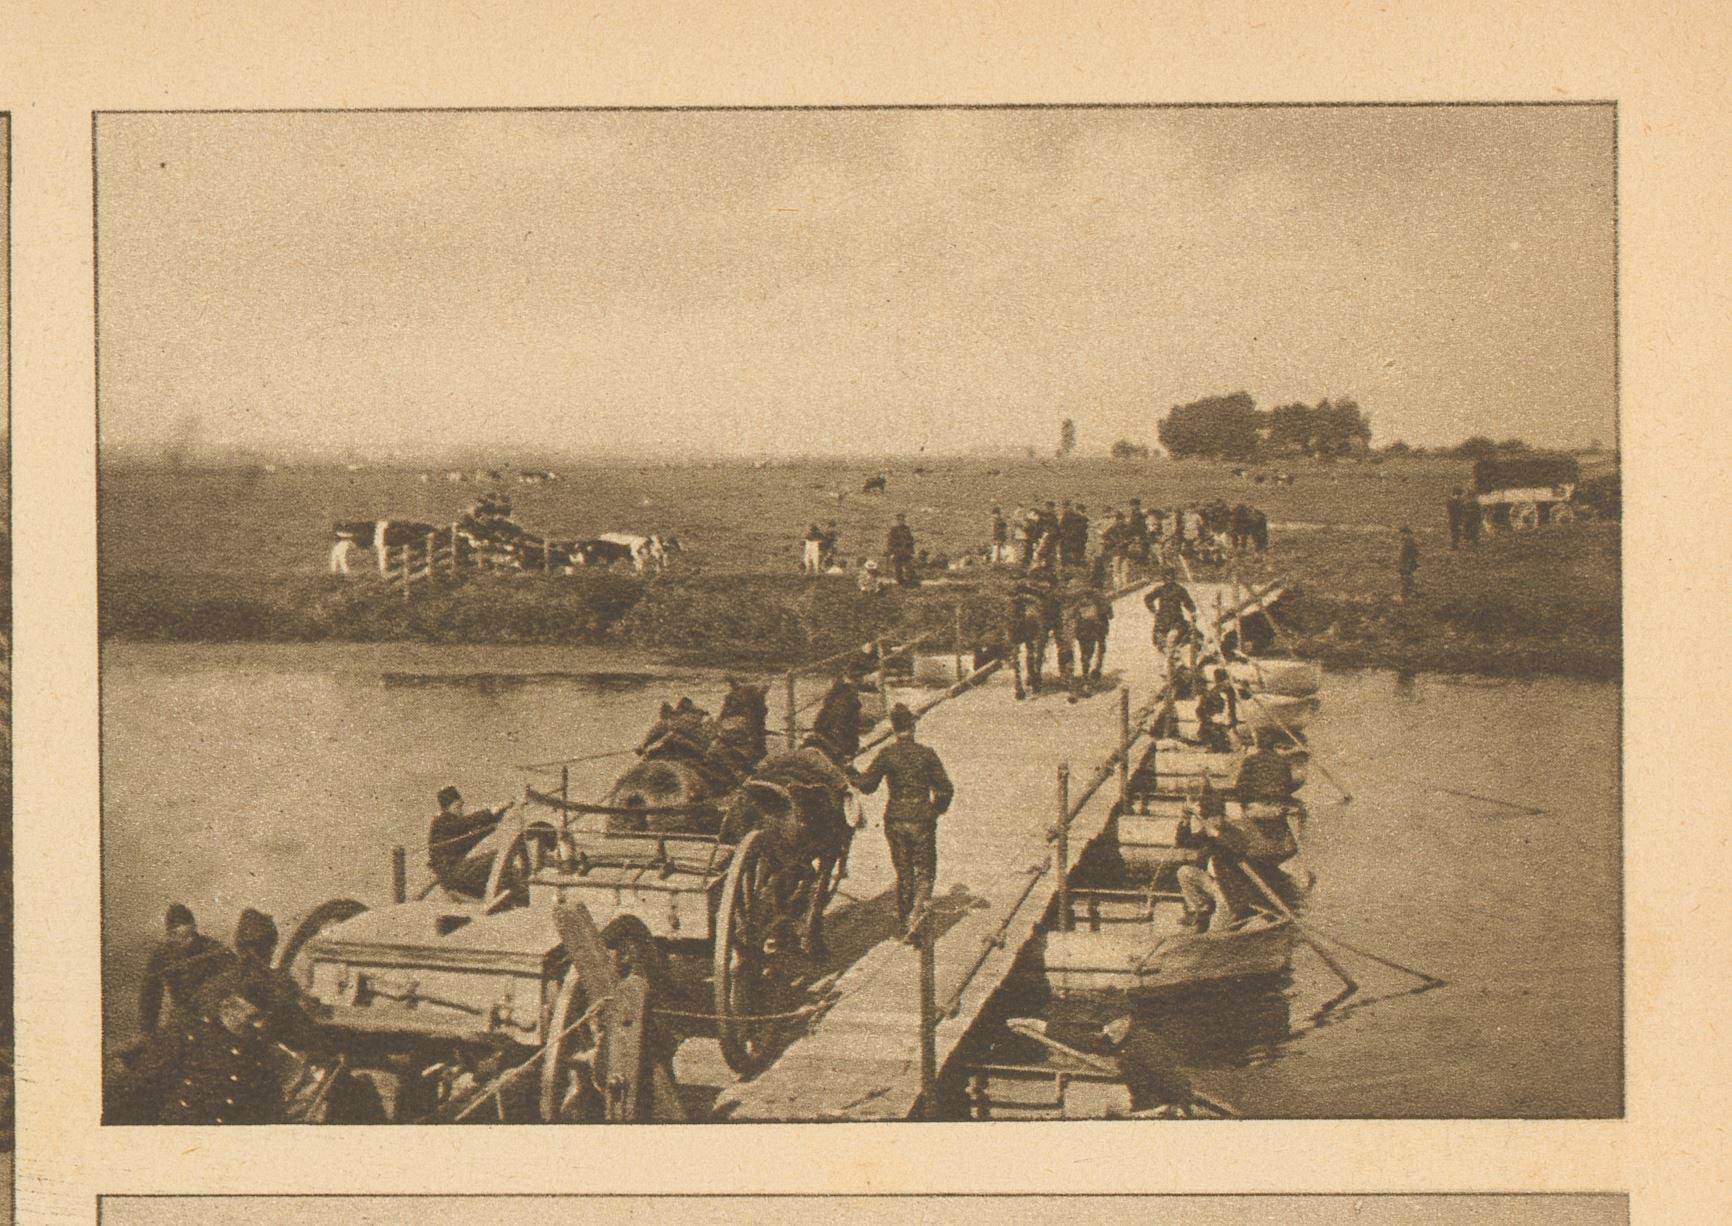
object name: album leaf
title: Brug over meerdere roeiboten, gebouwd door militairen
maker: Anonymous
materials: paper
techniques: rotogravure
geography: netherlands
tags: rowing-boat, canoe, etc., military training, bridge, netherlands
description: Deze prent maakt deel uit van een album.